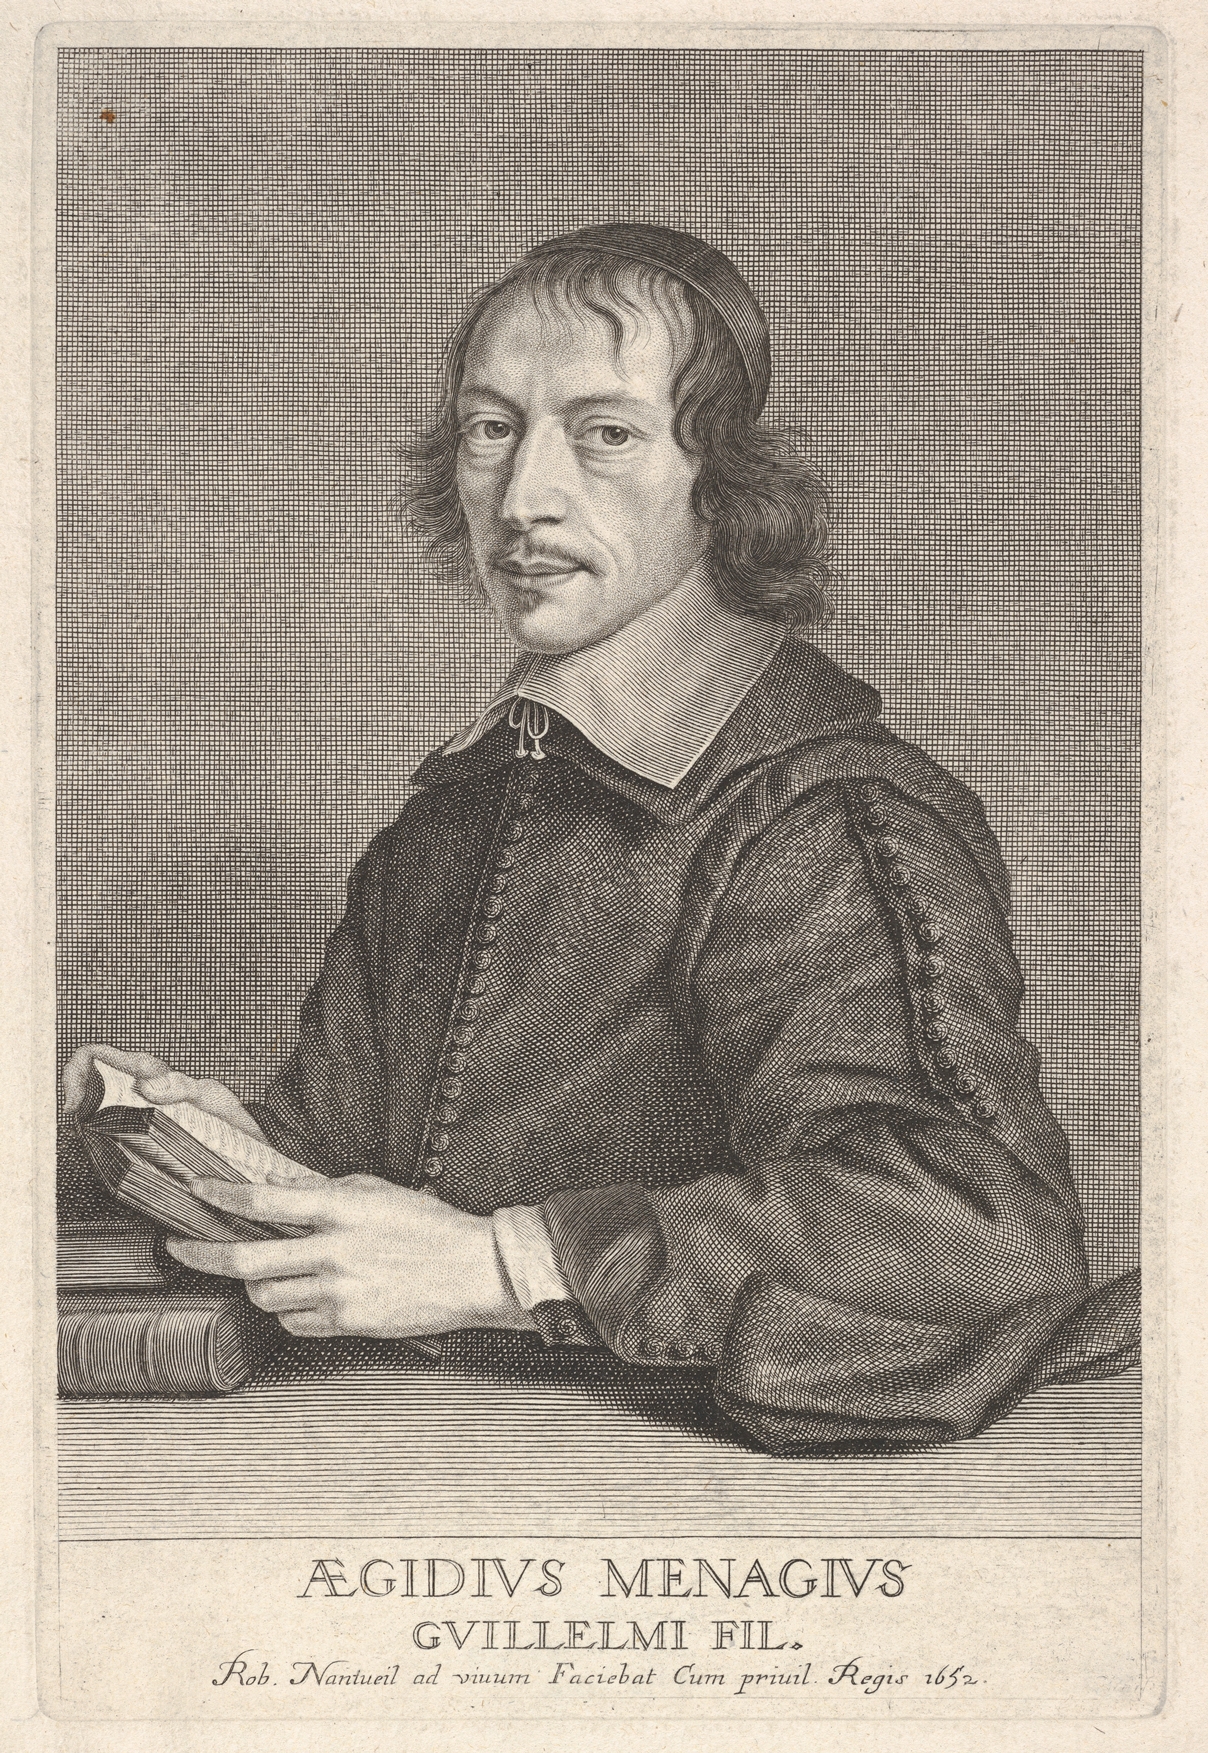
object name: print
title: Gilles Ménage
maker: robert nanteuil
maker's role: artist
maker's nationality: french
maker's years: 1623-1678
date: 1652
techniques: engraving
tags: men,portraits